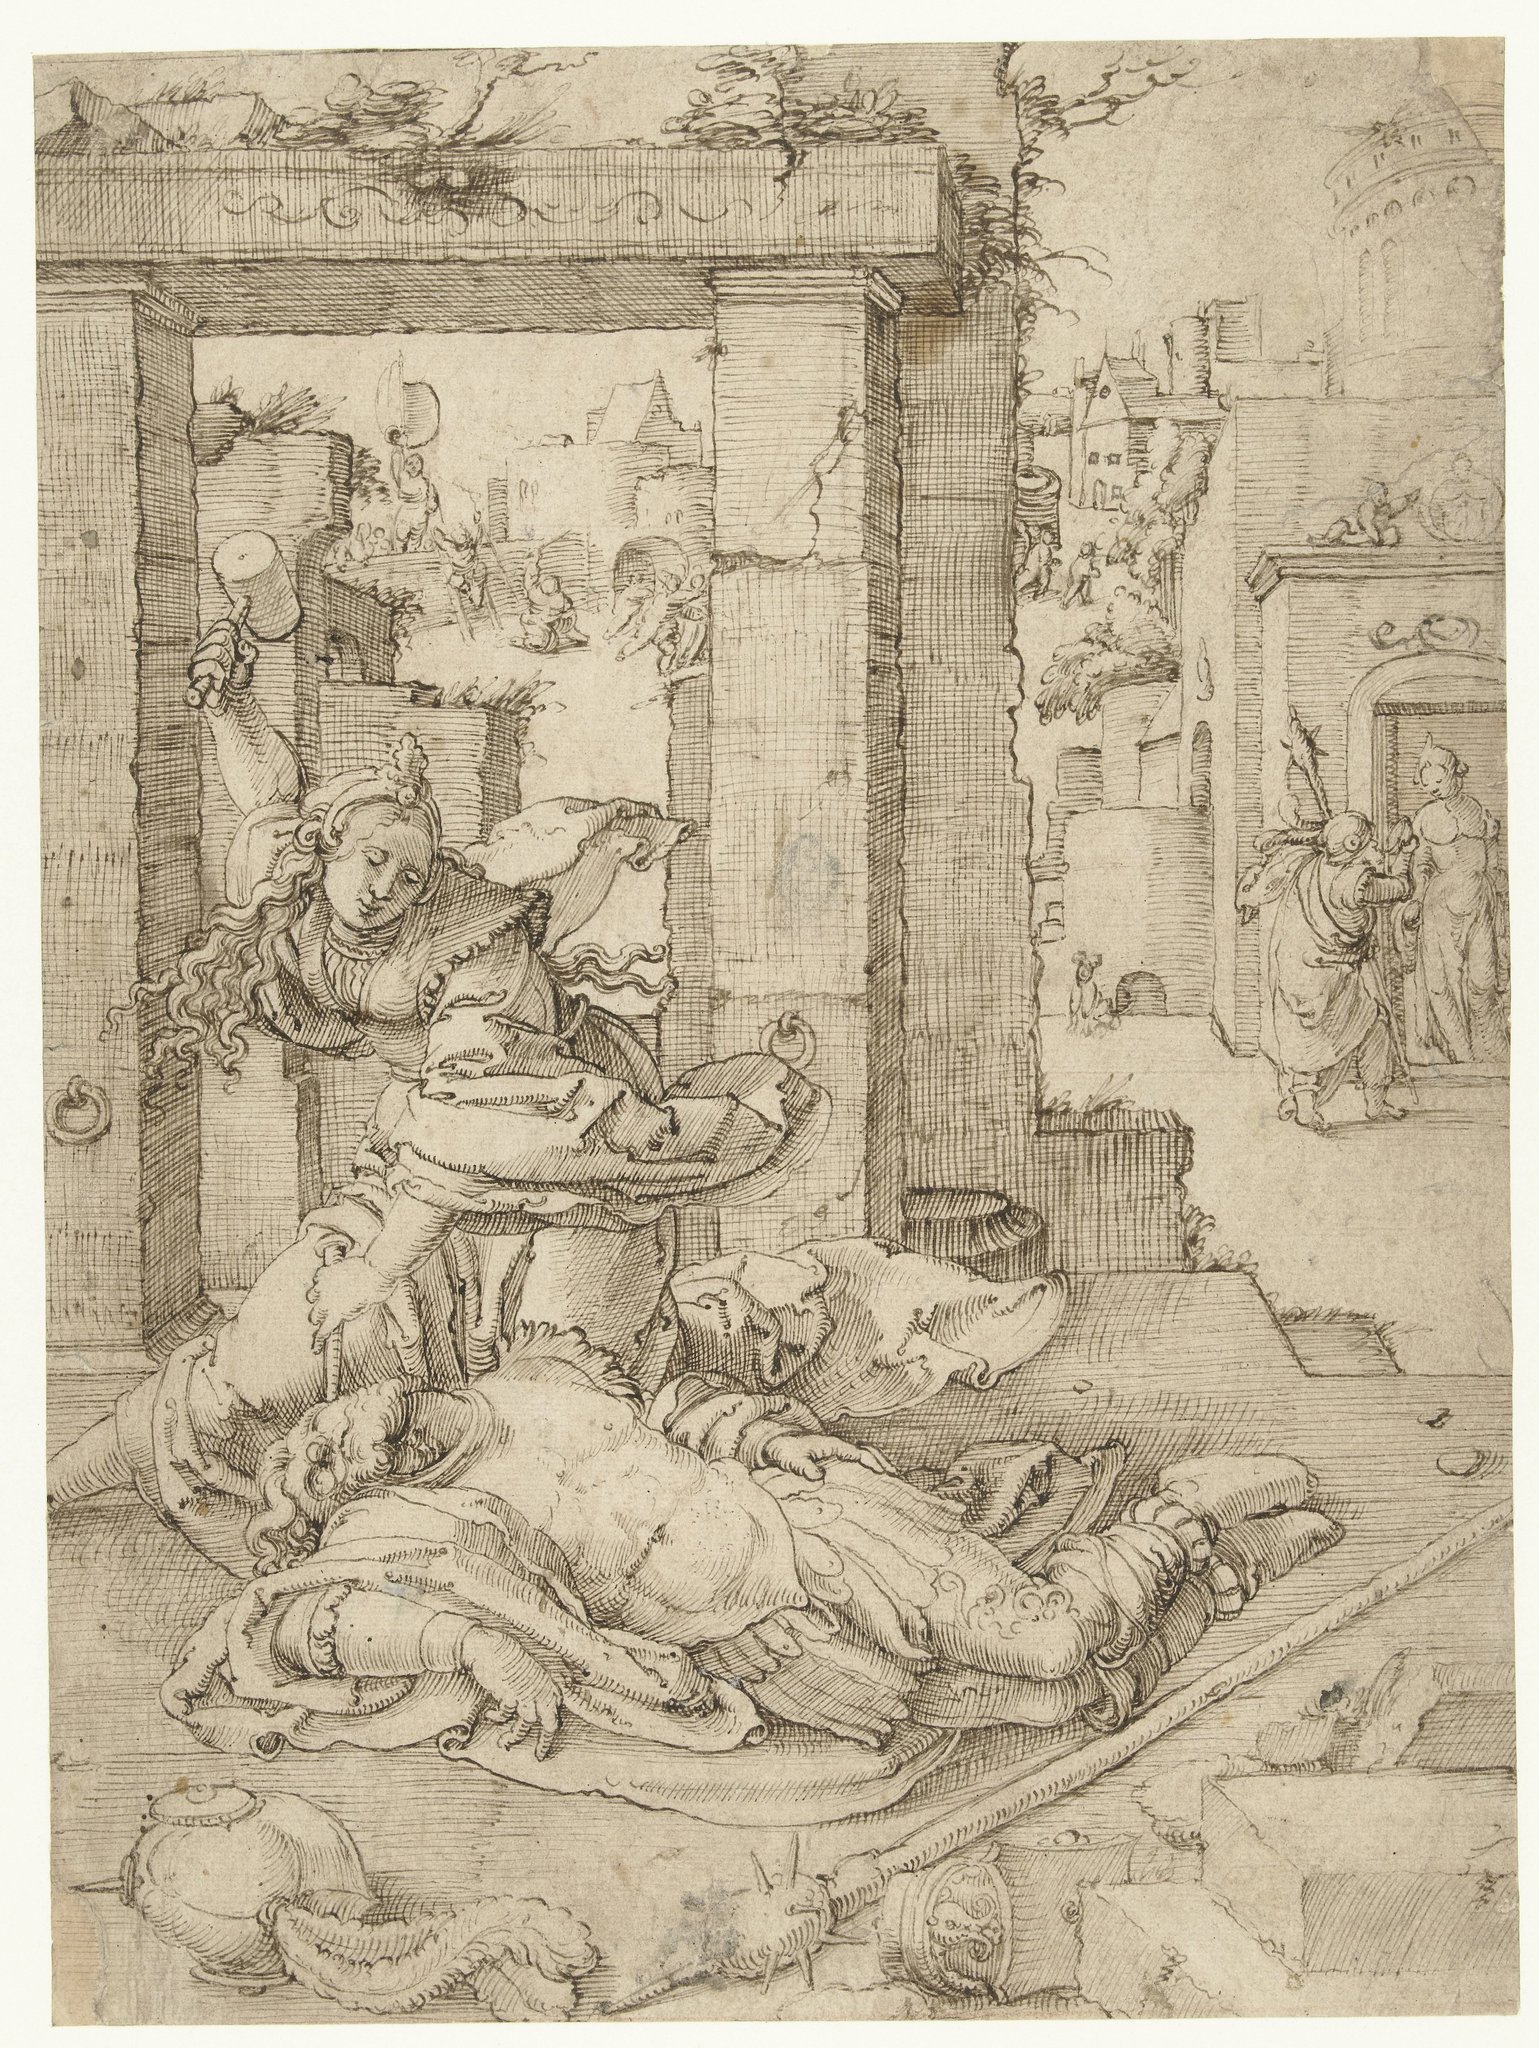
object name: drawing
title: Jael en Sisera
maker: Anonymous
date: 1517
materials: ink, paper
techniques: pen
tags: story of jael and sisera